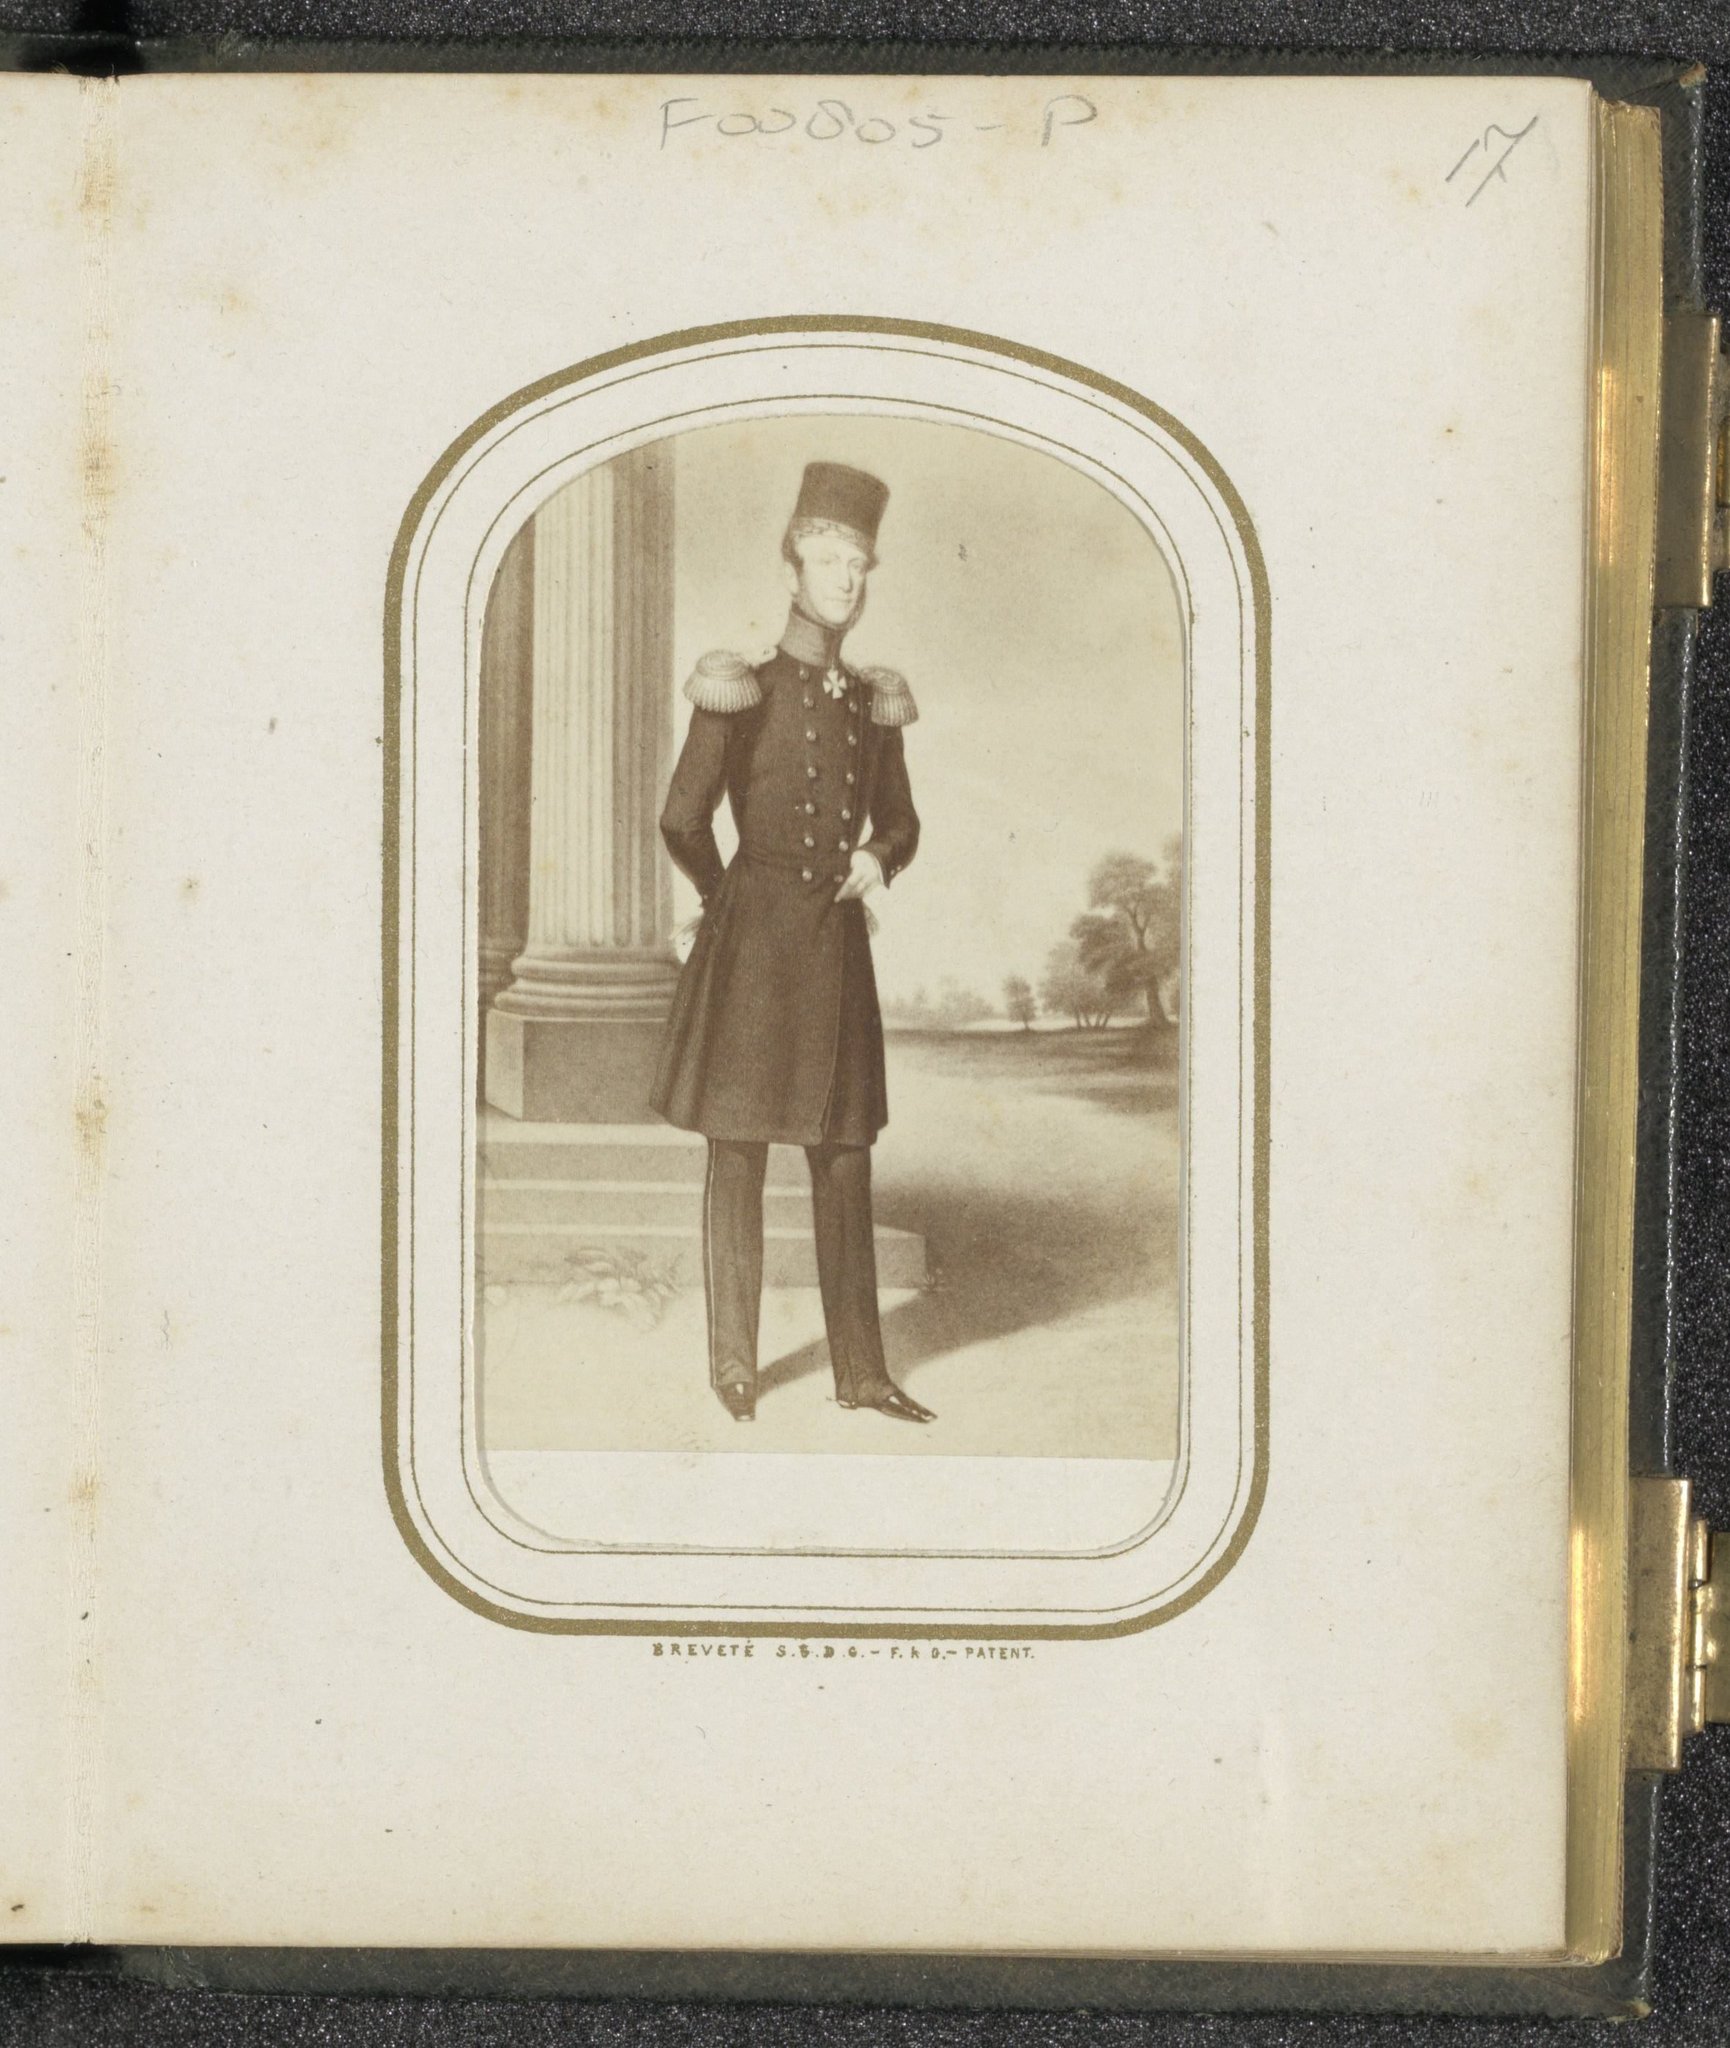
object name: carte de visite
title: Fotoreproductie van (vermoedelijk) een prent van Willem II, koning der Nederlanden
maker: Anonymous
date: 1860-1880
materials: cardboard, paper, photographic support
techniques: albumen print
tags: the hague, william ii of the netherlands, column, pillar ~ architecture, trousers, breeches, historical persons, head-gear: hat (+ men's clothes), shoes, sandals, ruler, sovereign, (military) uniforms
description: Onderdeel van Fotoalbum met 29 foto's van Nederlandse vorsten.